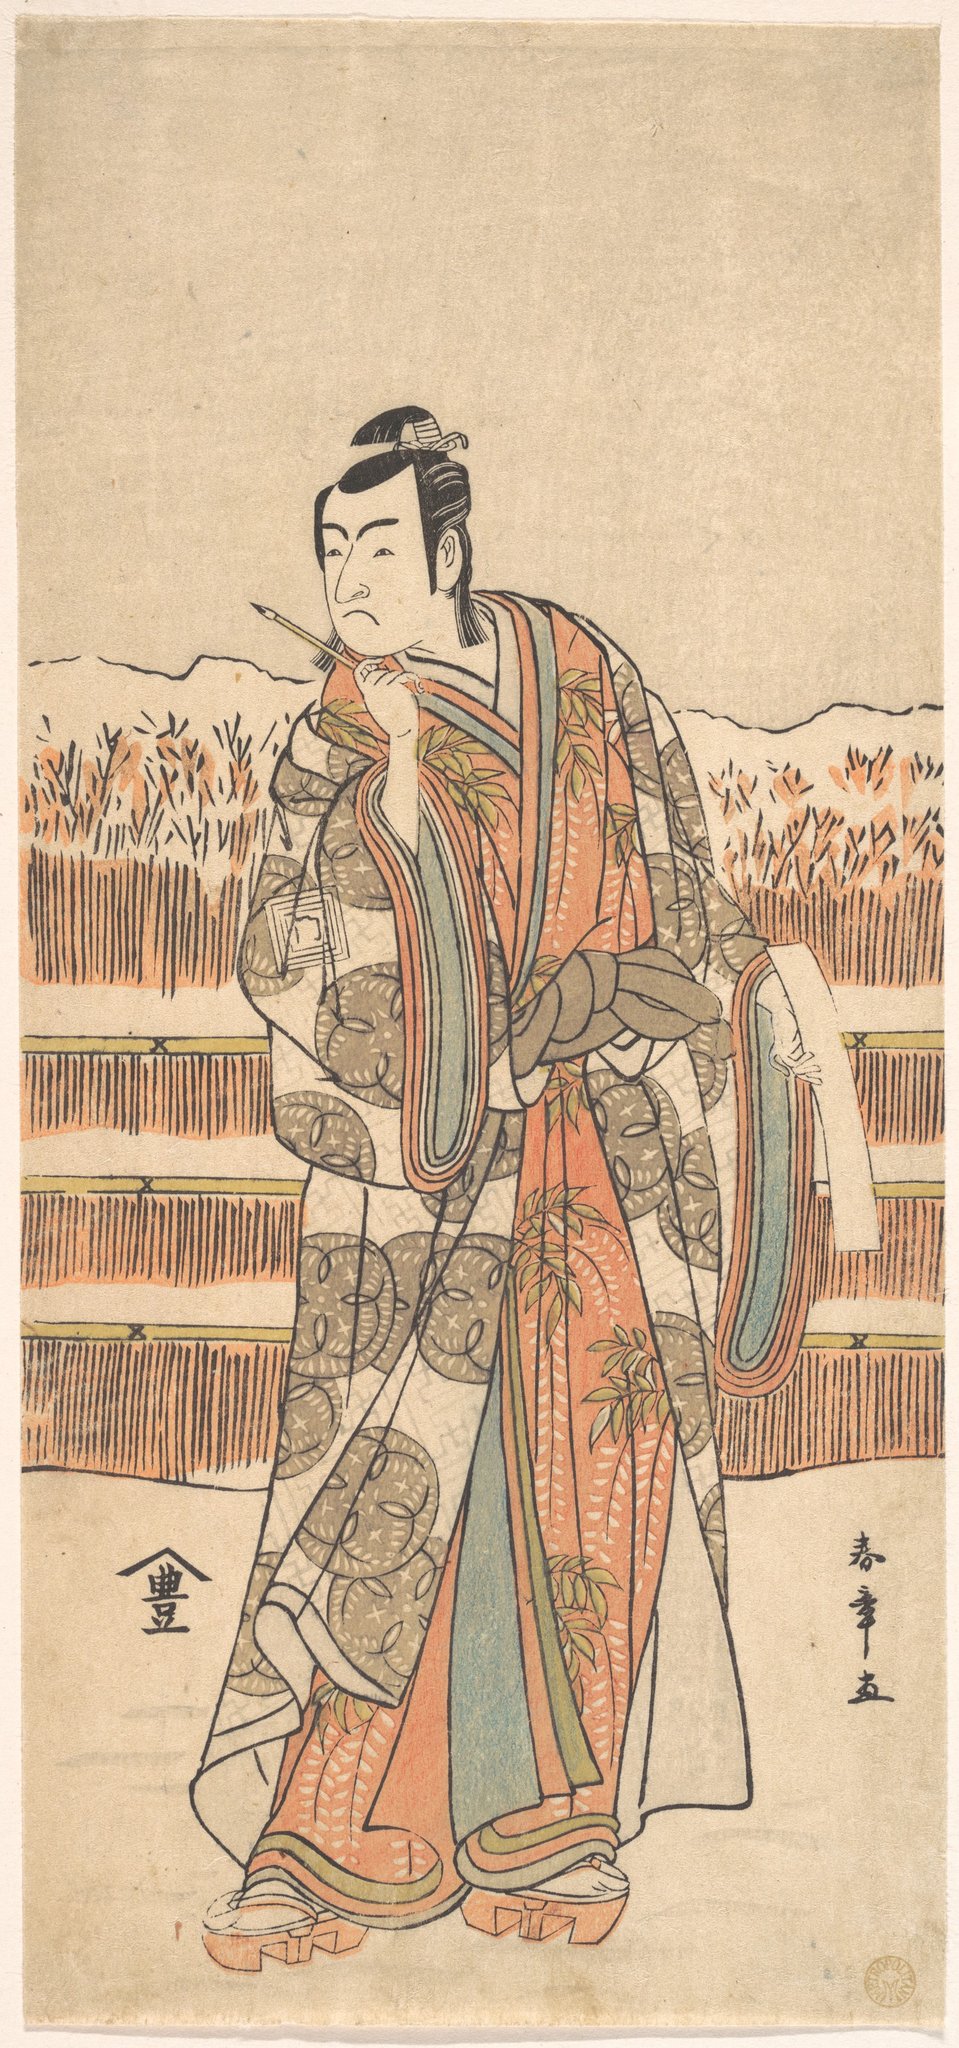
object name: woodblock print nishiki e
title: The Second Ichikawa Monnosuke as a Man of High Rank Standing in the Snow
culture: japanese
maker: katsukawa shunshō 勝川春章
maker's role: artist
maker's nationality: japanese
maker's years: 1726-1792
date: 1786-1787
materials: ink, paper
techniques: nishiki e, woodblock print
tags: men,snow,actors